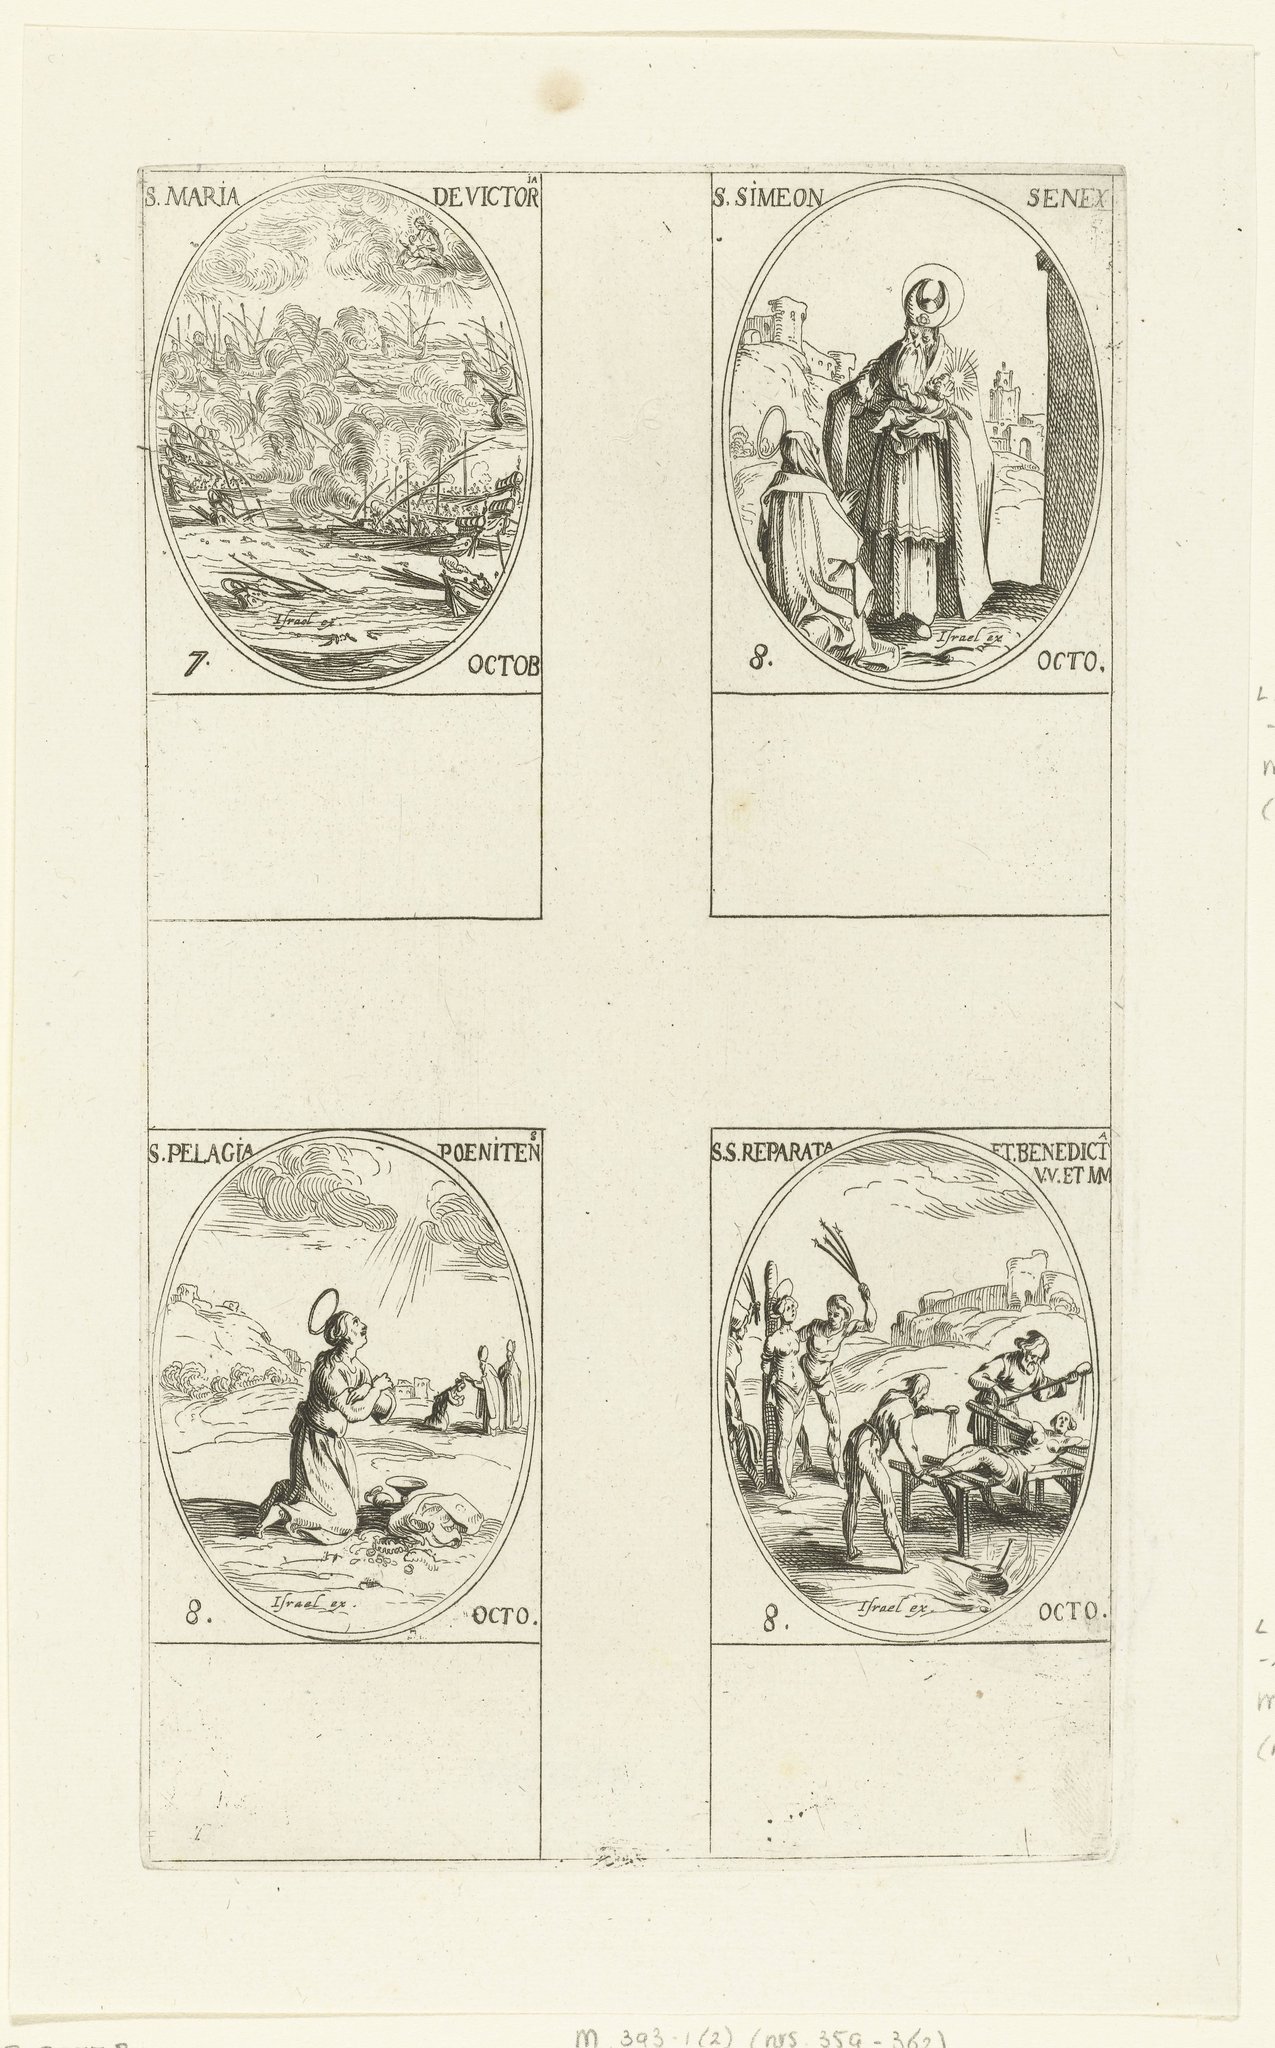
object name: print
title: Slag bij Lepanto (Maria-Overwinning), Heilige Simeon Senex van Jeruzalem, Heilige Pelagia van Antiochië, Heilige Reparata van Caesarea en Heilige Benedicta van Laon (7-8 oktober)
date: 1632-1636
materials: paper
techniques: etching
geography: paris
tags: battle, female saints (with name), simeon christophorus (the just, the grey); possible attributes: the infant christ in his arms, navy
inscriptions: collector's mark: Lugt 240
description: Blad met vier ovale voorstellingen, elk met opschrift en datum in het Latijn: linksboven de zeeslag bij Lepanto, rechtsboven de Heilige Simeon met het Christuskind op de arm, linksonder de Heilige Pelagia van Antiochië geknield voor de kleding en sieraden die ze afgelegd heeft, rechtsonder de Heilige Reparata van Caesarea die gemarteld wordt met vloeibaar lood en de Heilige Benedicta van Laon die gegeseld wordt. Deze prent is onderdeel van een serie prenten met voorstellingen van de heiligen en de christelijke feestdagen van het jaar. Er zijn steeds vier scènes van één plaat op één blad gedrukt. Inclusief bijbehorend titelblad en frontispice gaat het in totaal om 124 platen (490 voorstellingen). De drie platen met de laatste 12 scènes (de veranderlijke christelijke feestdagen) zijn in de derde staat versneden tot 12 kleine plaatjes, en met een apart titelblad uitgegeven.